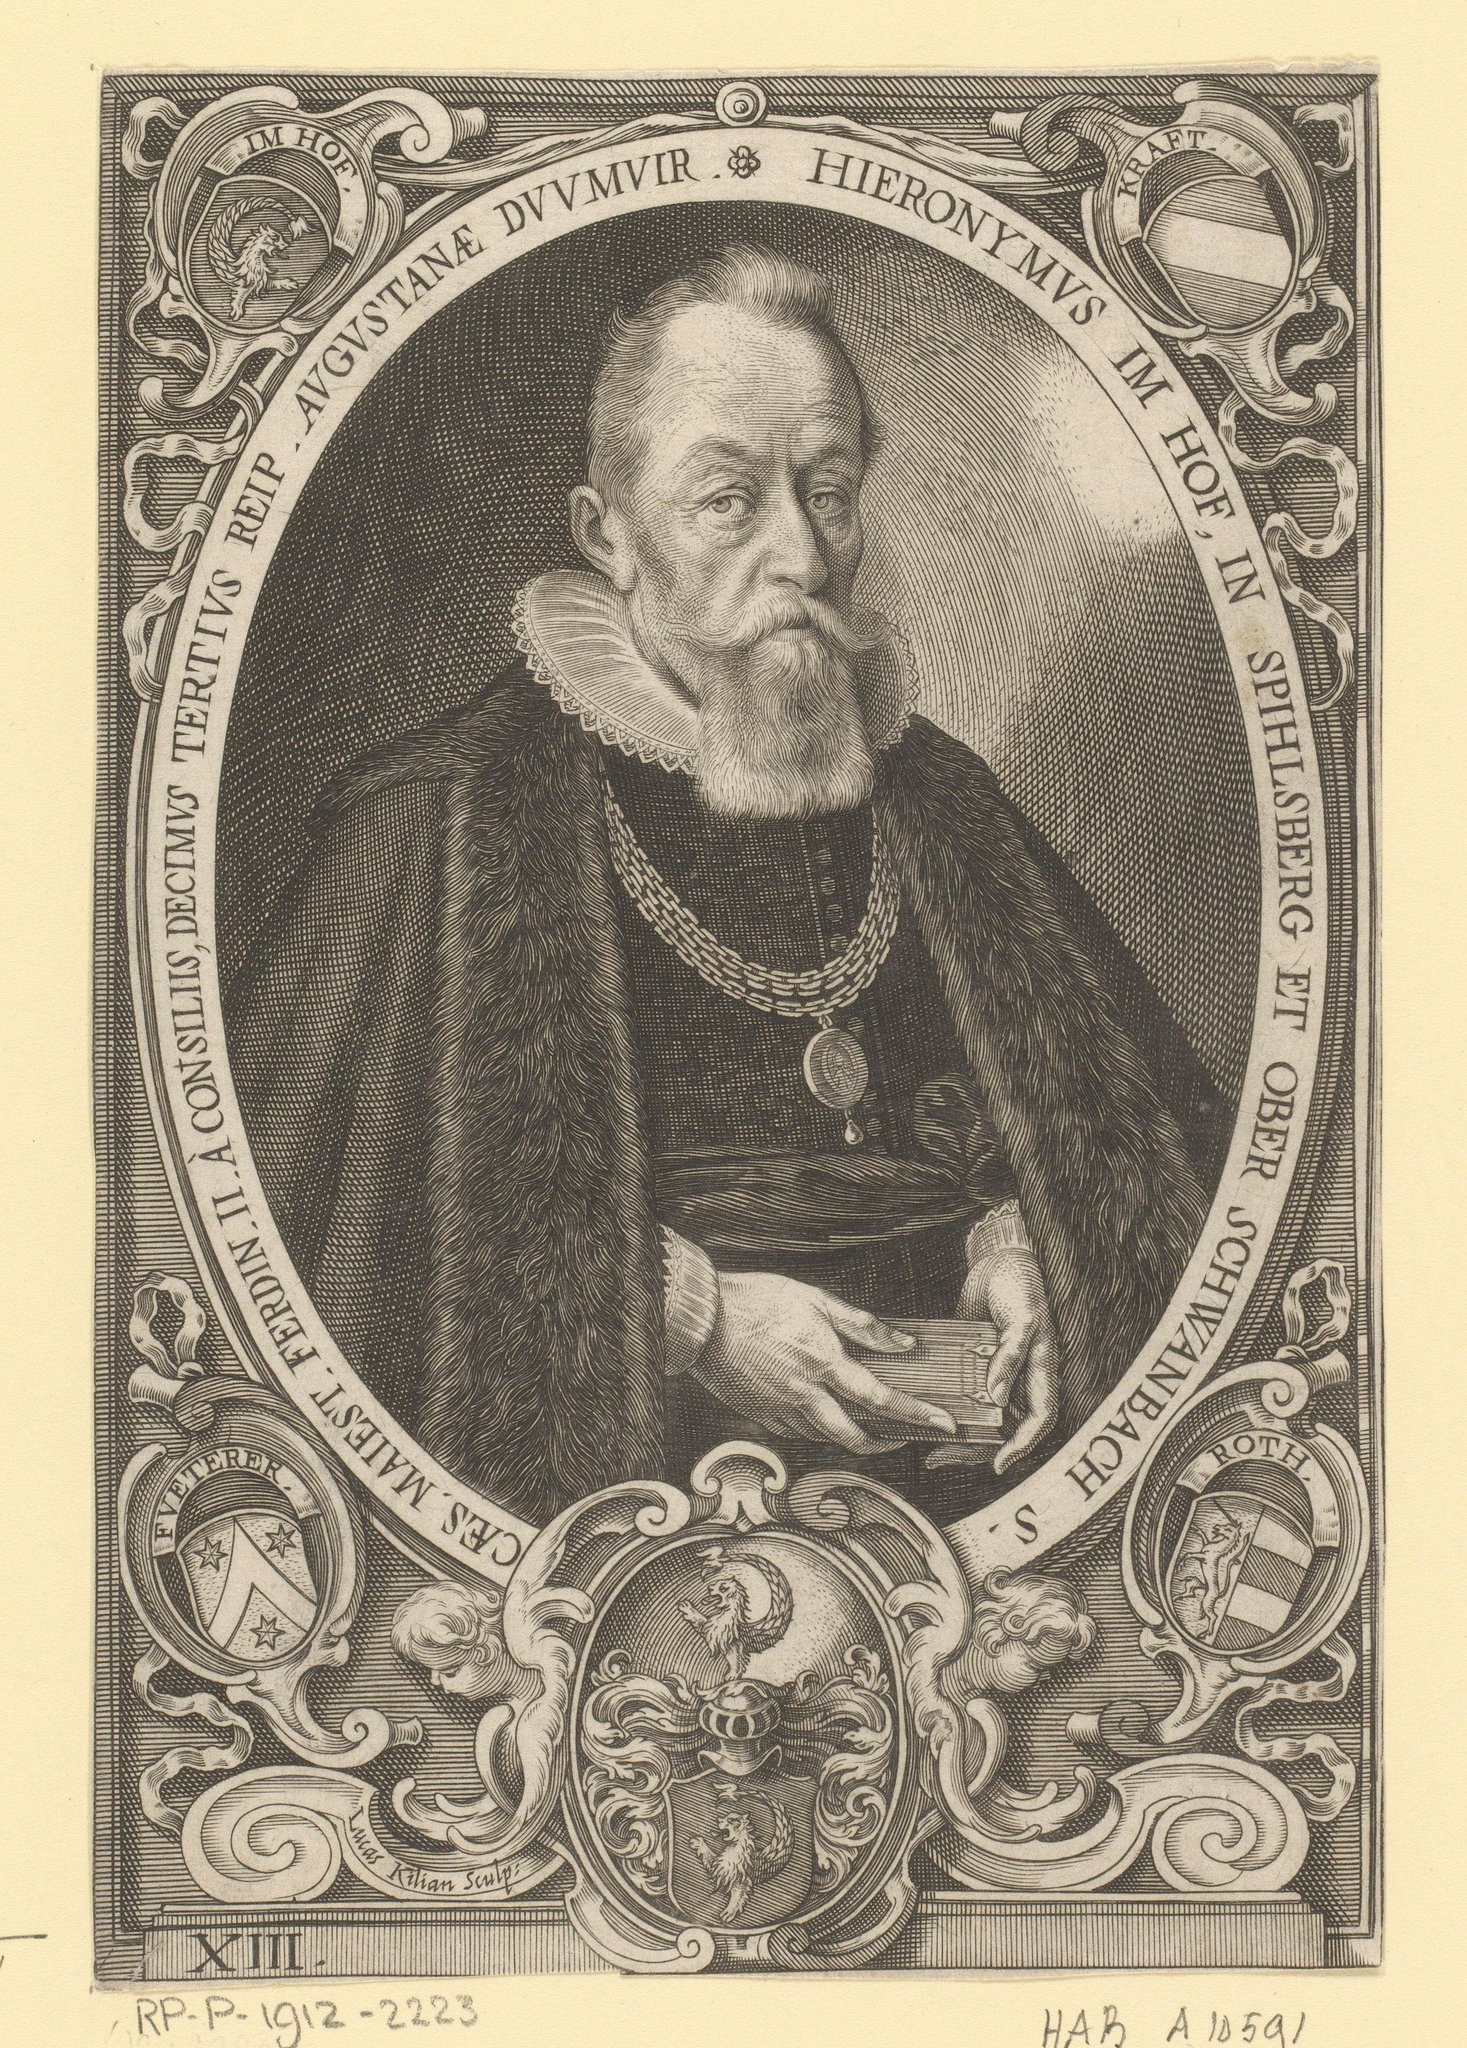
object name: print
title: Portret van Hieronymus Imhof (II)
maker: lucas kilian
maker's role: draughtsman, print maker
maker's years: 1579-1637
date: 1624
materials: paper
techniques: engraving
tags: augsburg, historical persons, book, armorial bearing, heraldry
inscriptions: collector's mark: Lugt 2228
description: Prent gebruikt in: Imp. Caes. Caroli V.S.A. (...). Ausburg: Lucas Kilian, 1624.